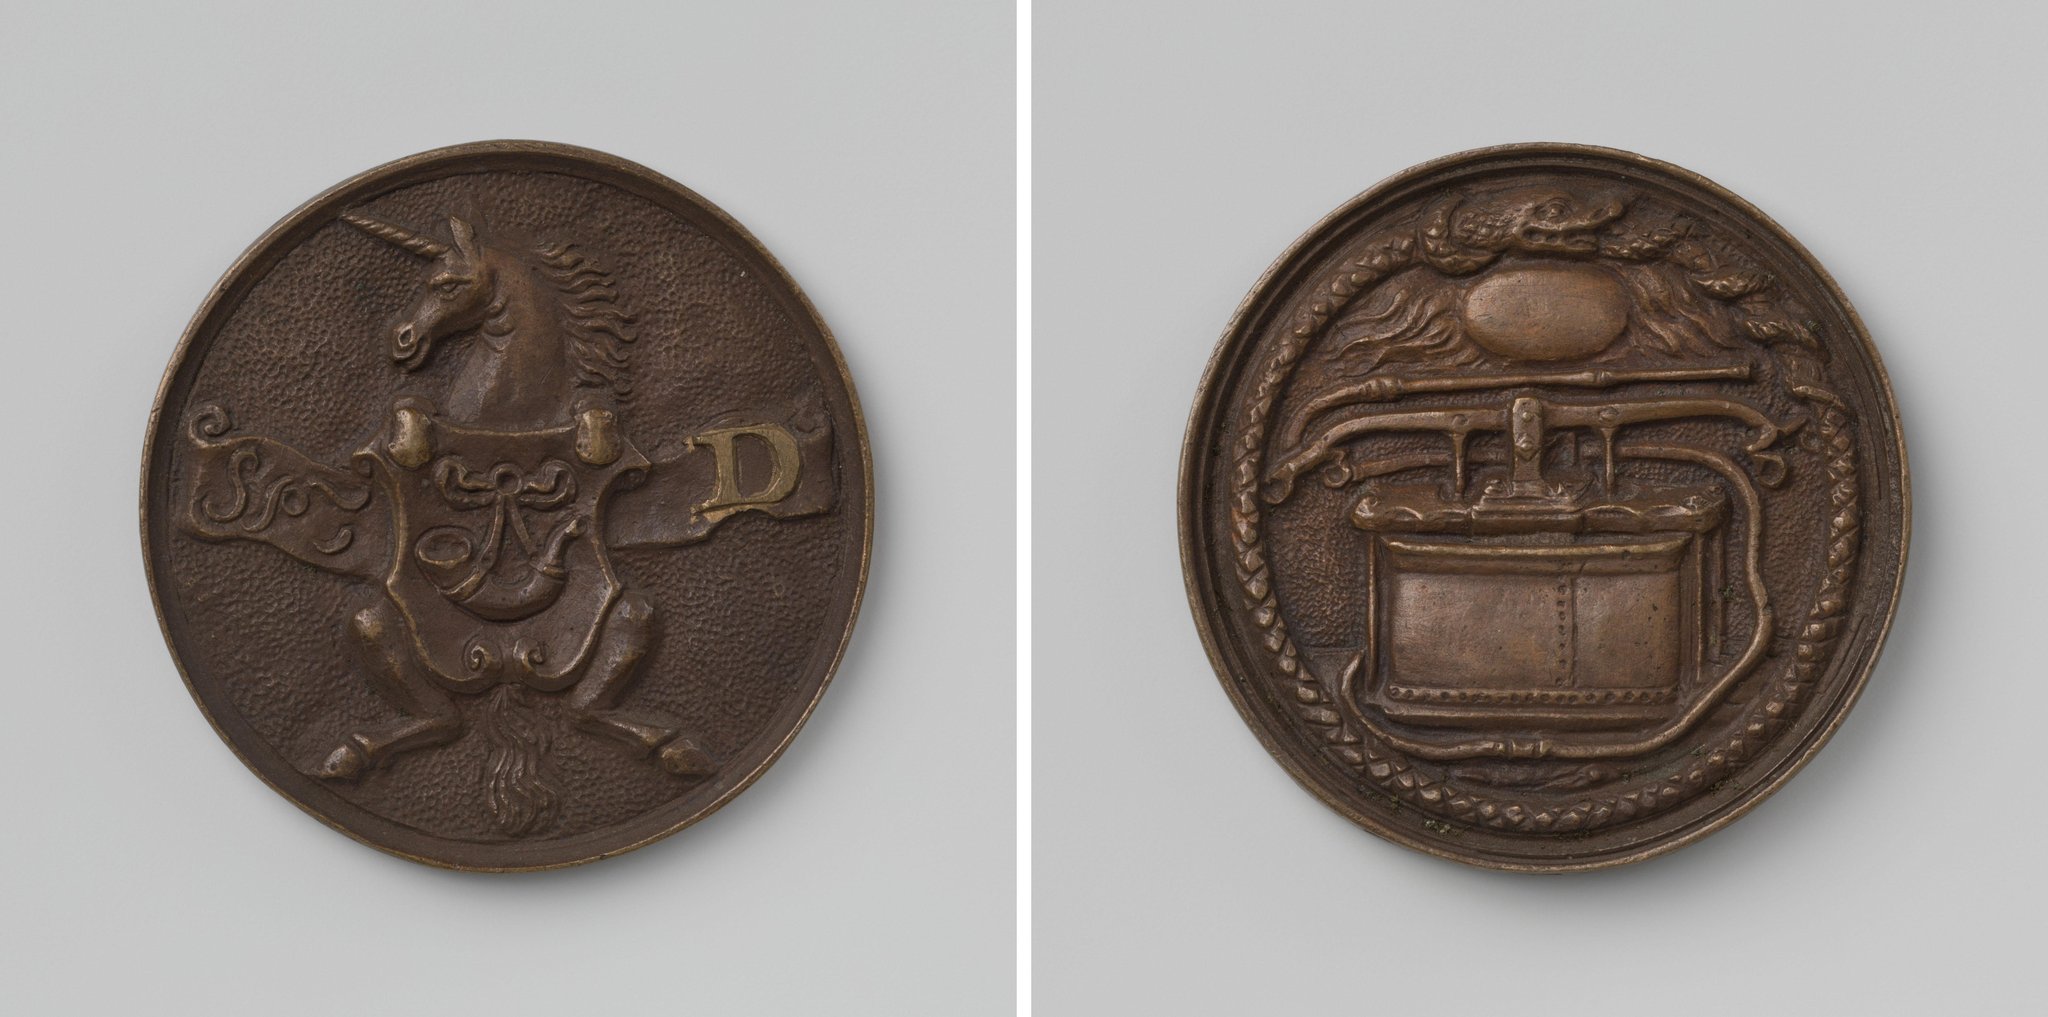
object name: fire engine medal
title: Hoorn, brandspuitpenning van spuit D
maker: Anonymous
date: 1680-1800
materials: brass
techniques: casting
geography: hoorn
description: Messing penning. Voorzijde: naar links gewende eenhoorn met wapenschild, omhangen met lint met opschrift. Keerzijde: brandspuit onder leeg cartouche binnen slangerond